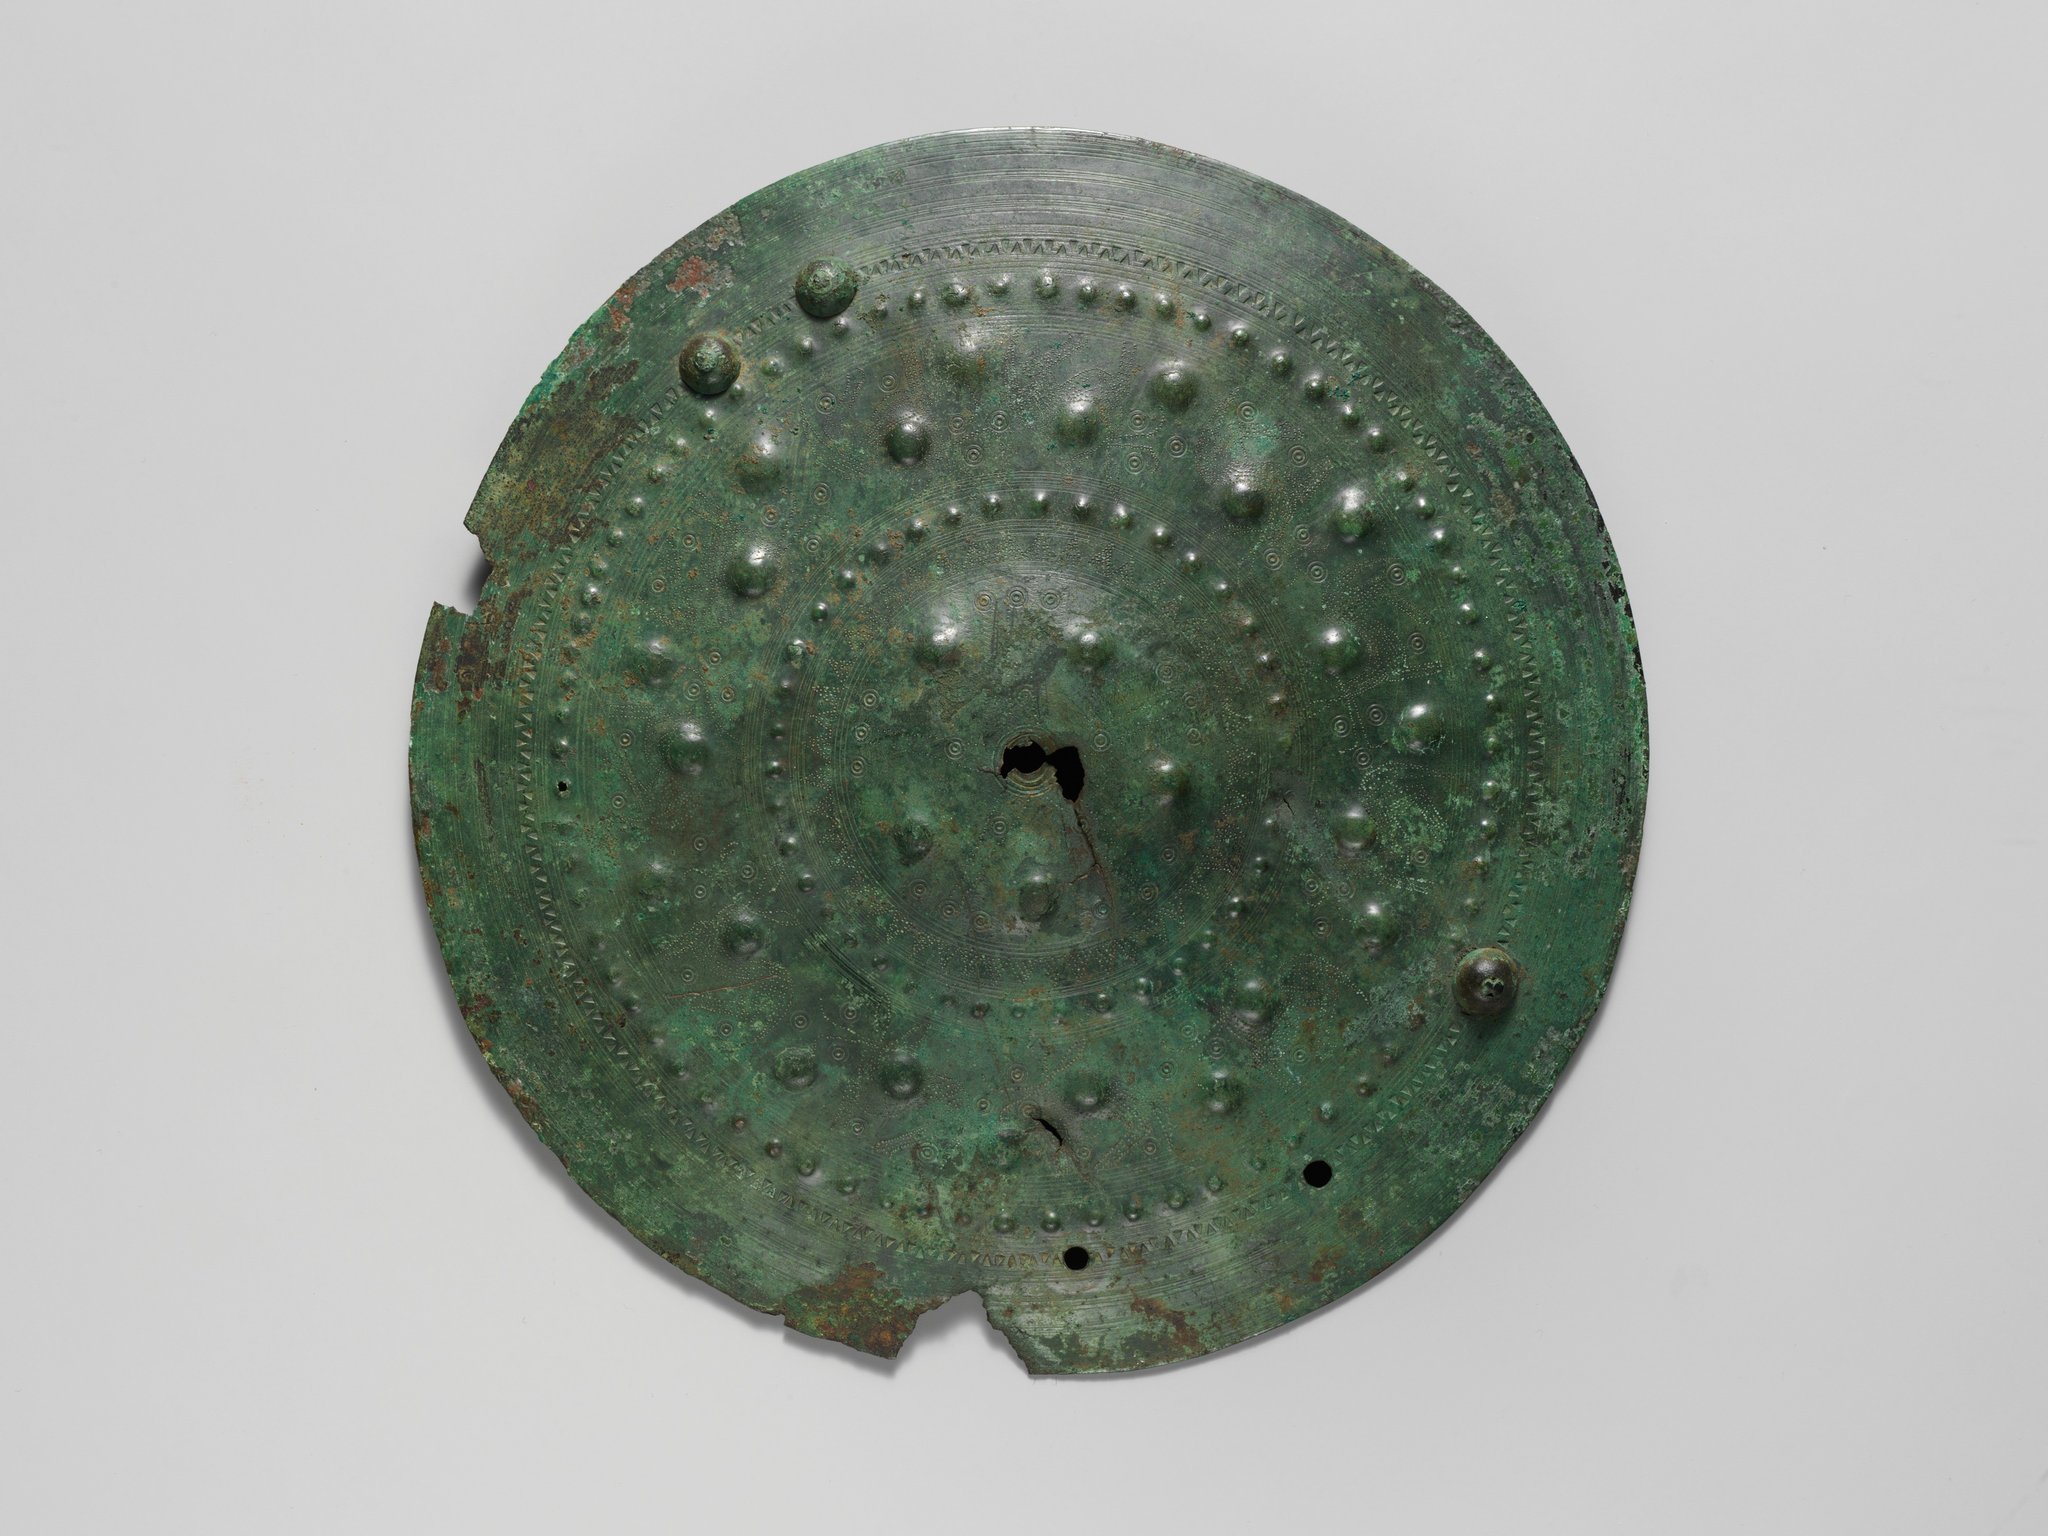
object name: shield bos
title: Bronze shield boss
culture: italic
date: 700-601 BCE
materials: bronze